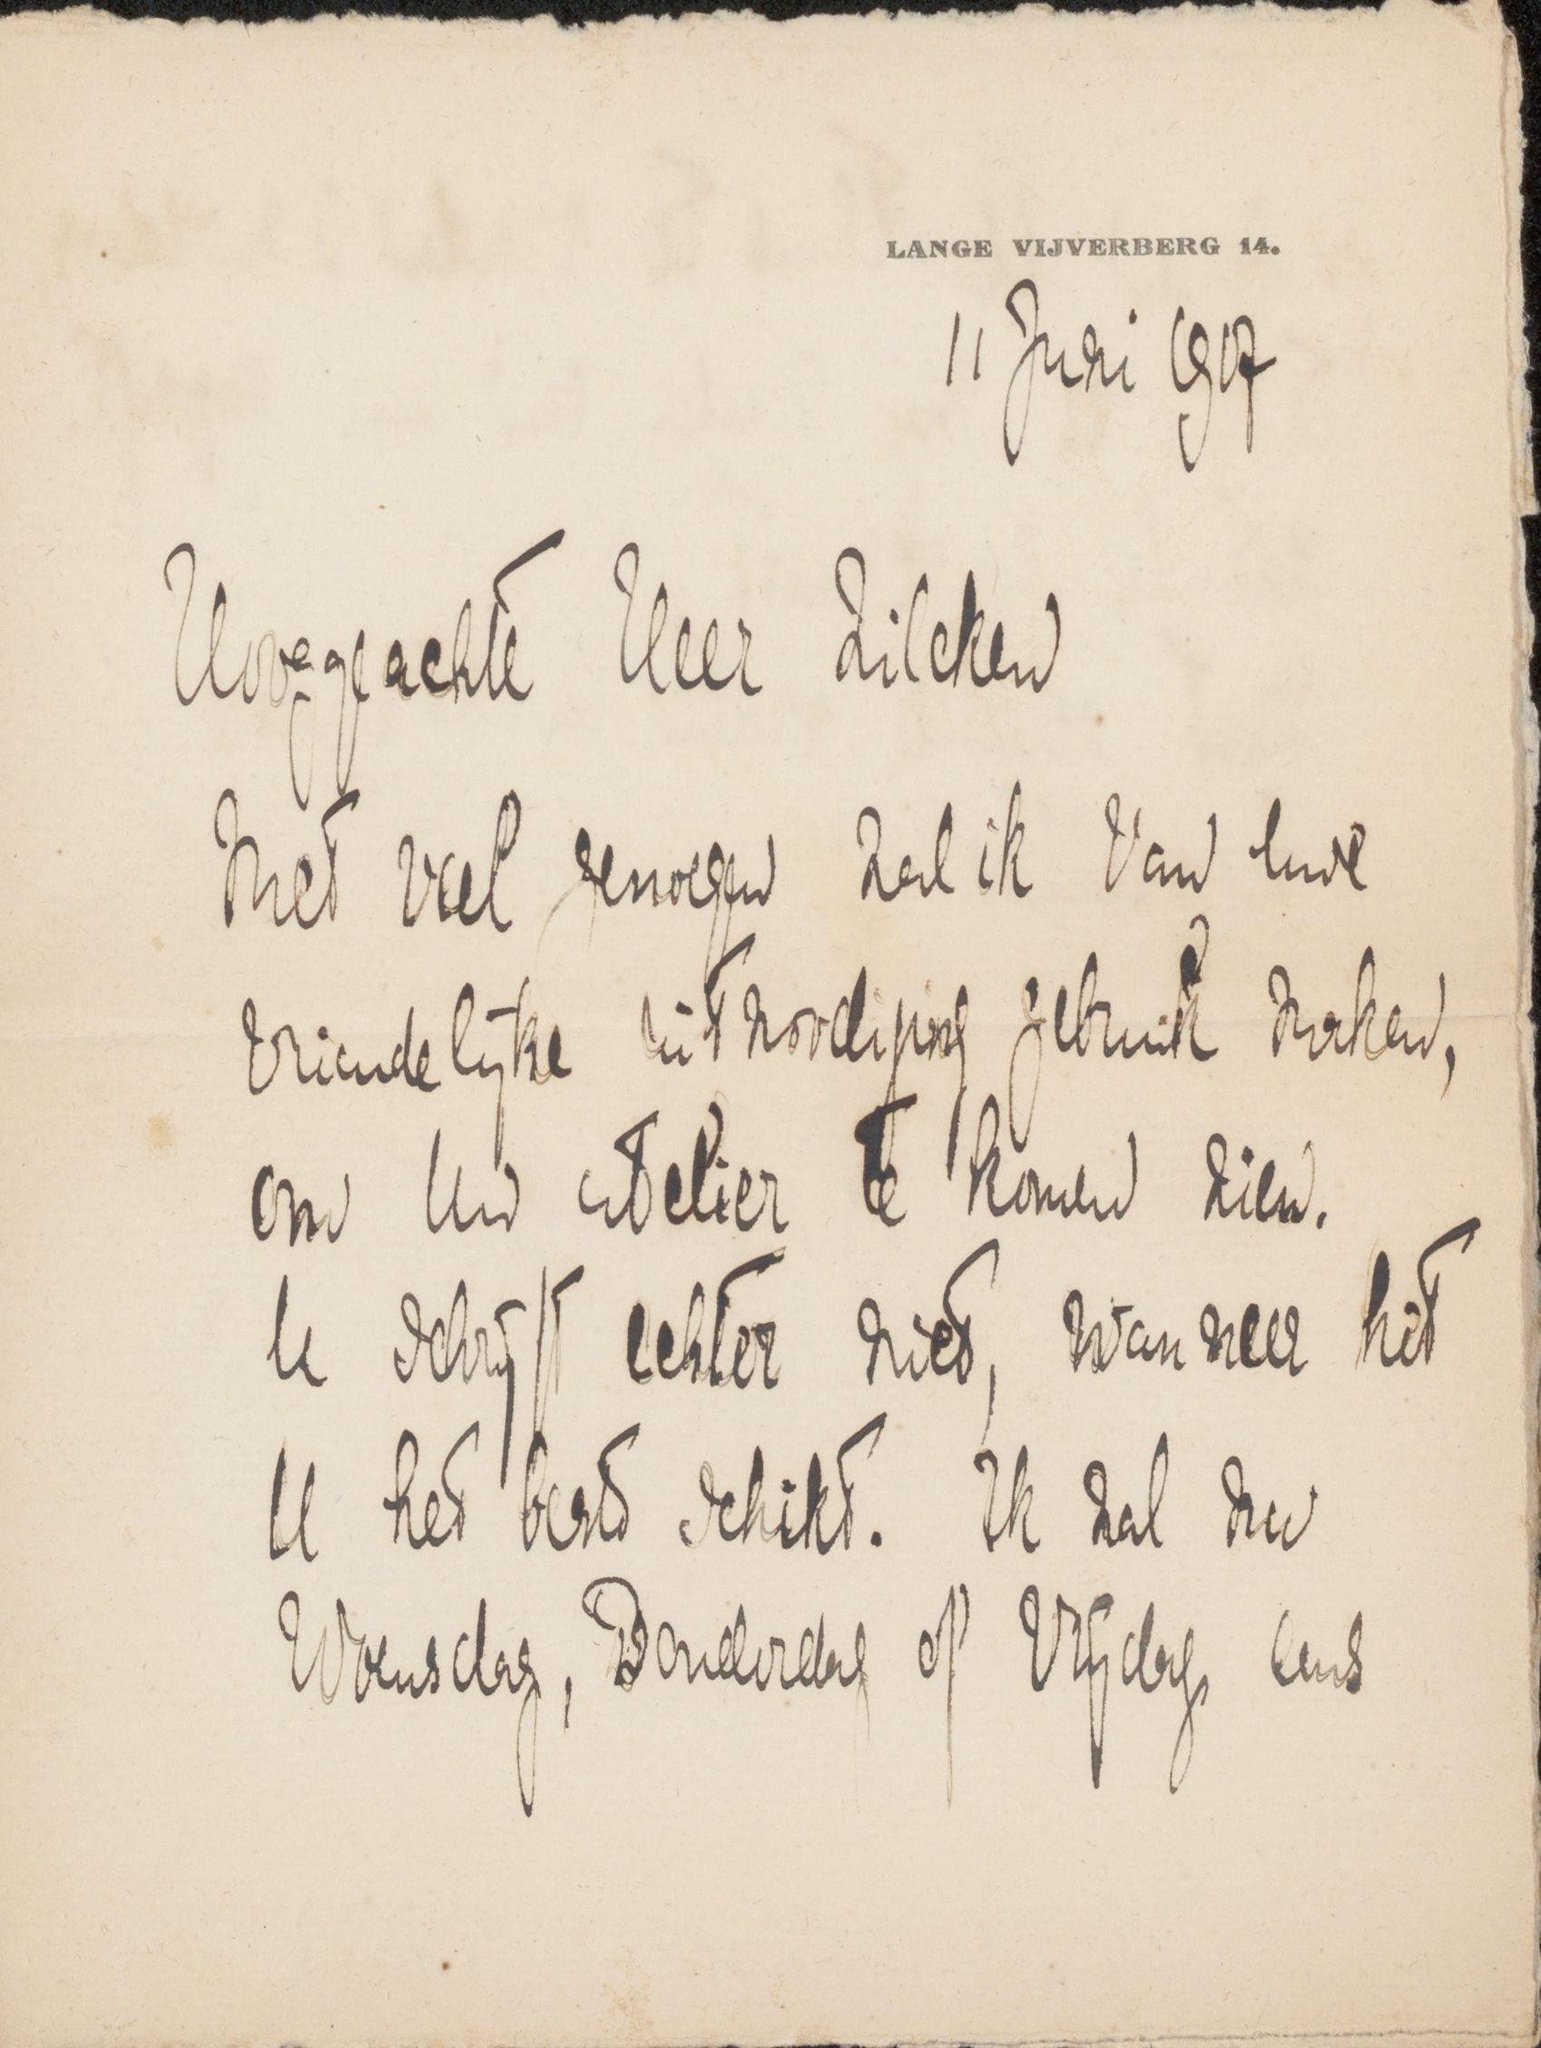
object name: letter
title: Brief aan Philip Zilcken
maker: r. cremers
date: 1907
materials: ink, paper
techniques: pen, printing, writing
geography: the hague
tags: the hague, painter, draughtsman, philip zilcken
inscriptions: collector's mark: ‘RPK’, watermark